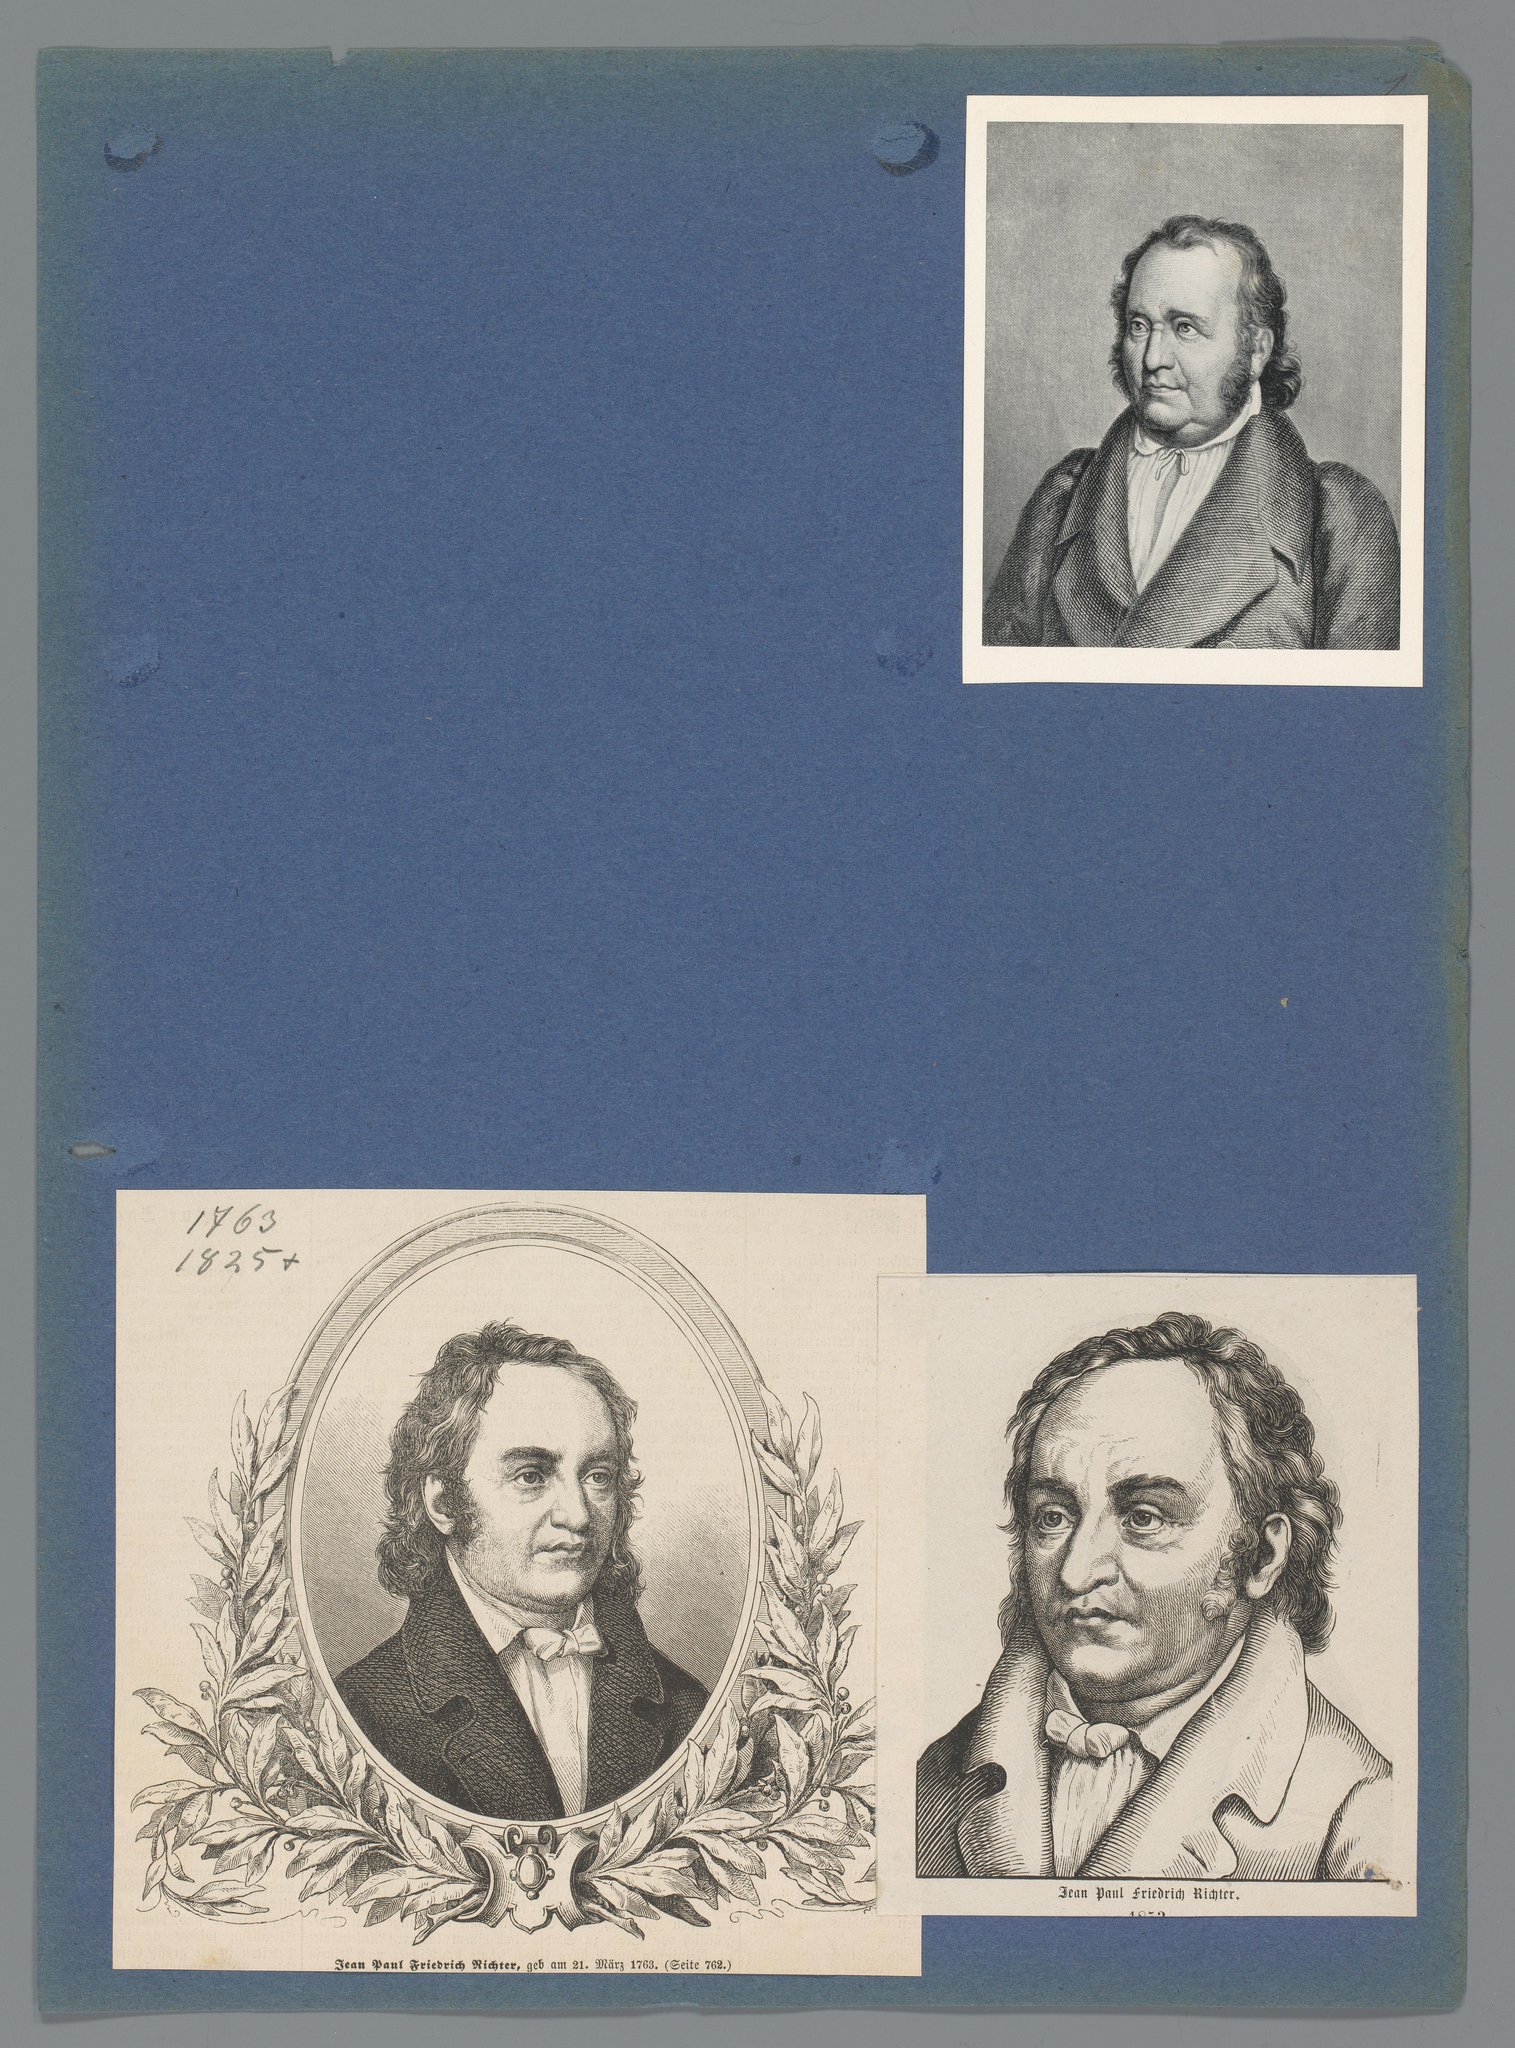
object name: print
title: Blad met drie portretten van Jean Paul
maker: Anonymous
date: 1850-1900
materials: paper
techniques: snipping, engraving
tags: jean paul, historical persons, portrait of a writer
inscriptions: number: ‘1.’